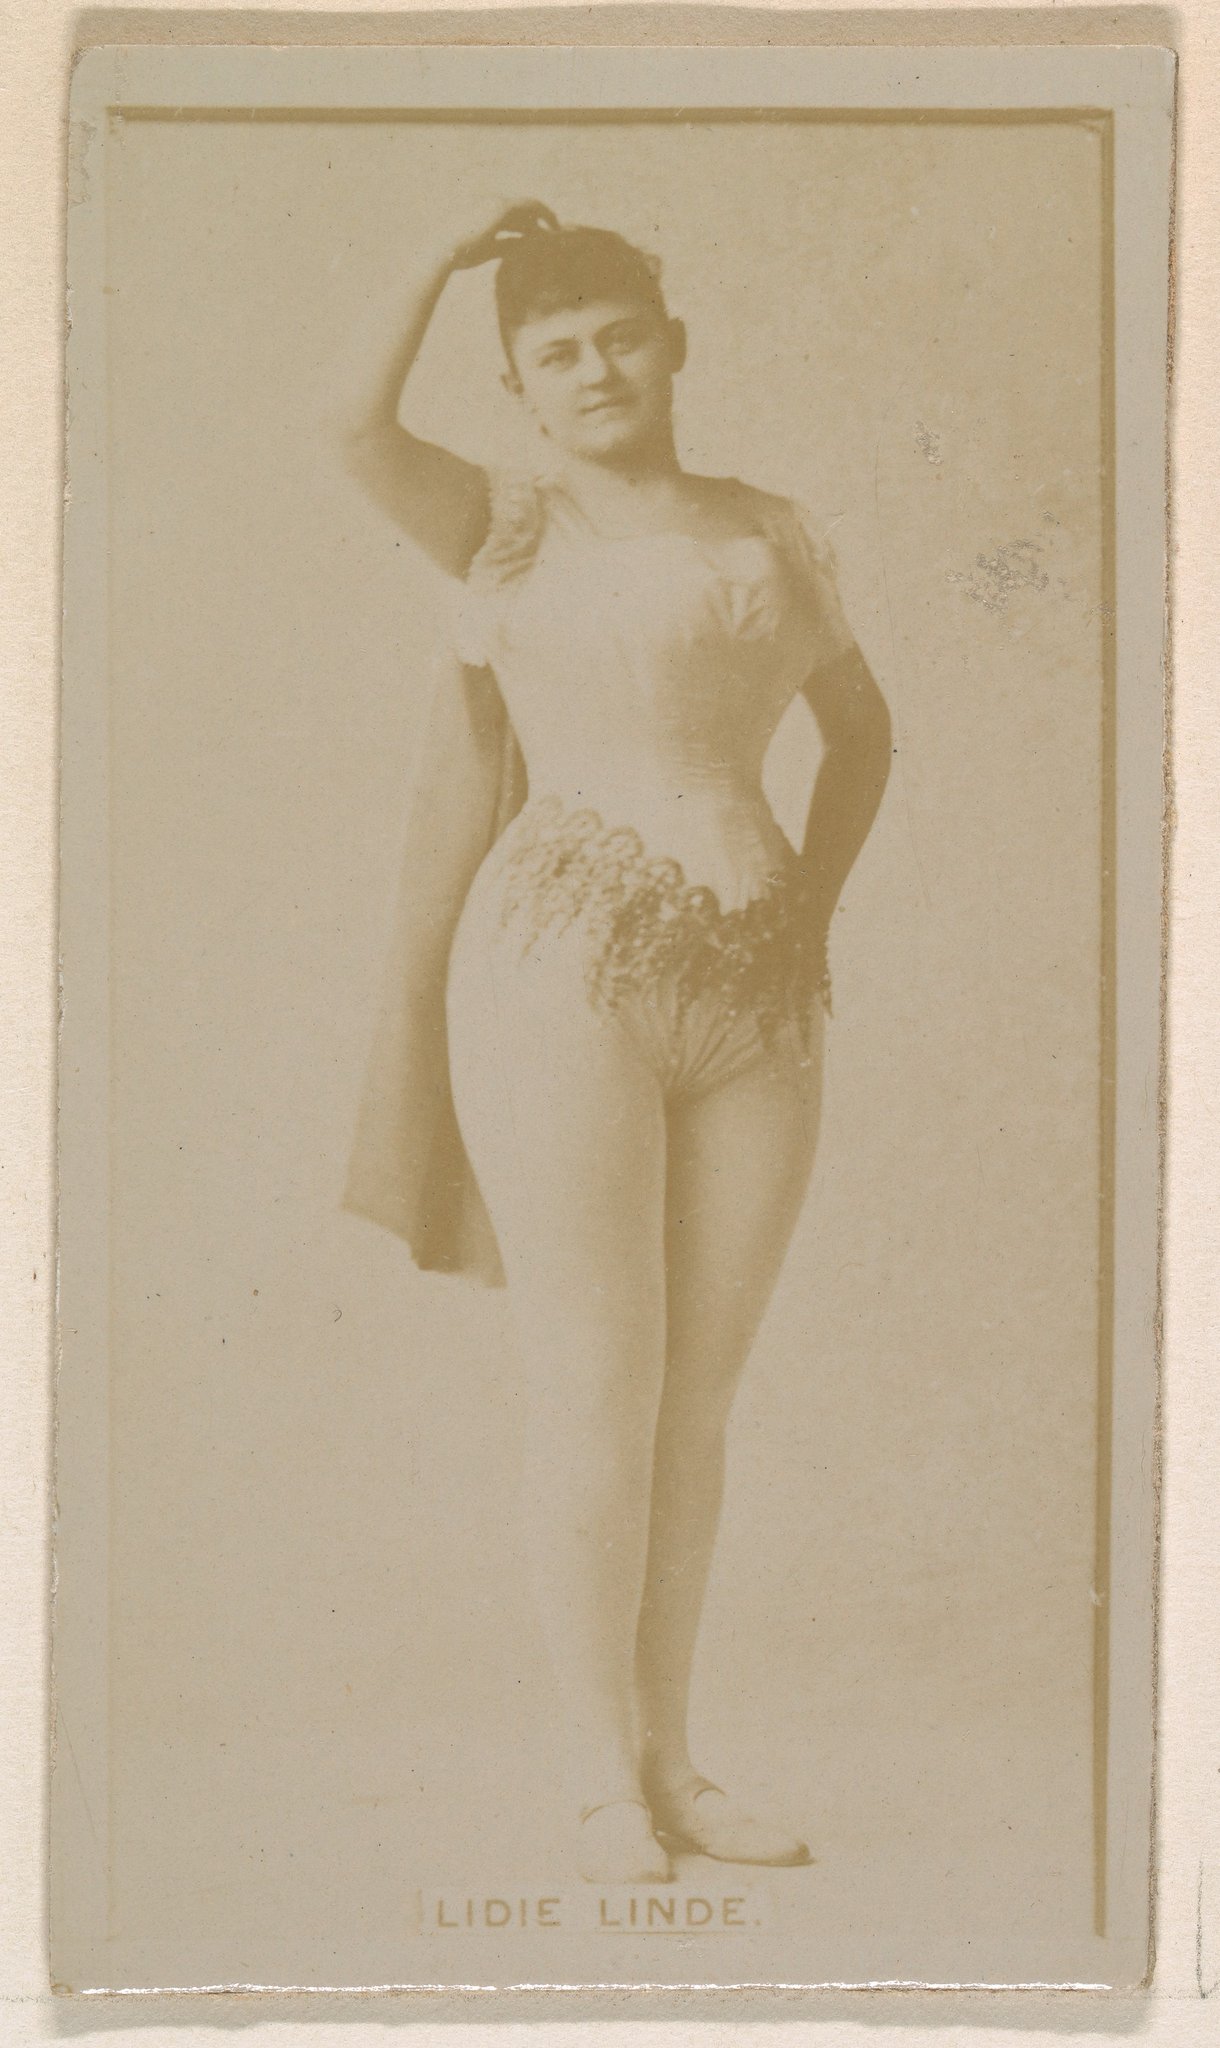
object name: photograph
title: Lidie Linde, from the Actresses series (N245) issued by Kinney Brothers to promote Sweet Caporal Cigarettes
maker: kinney brothers tobacco company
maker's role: publisher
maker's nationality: american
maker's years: 1869-2011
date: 1890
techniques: albumen silver print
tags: portraits,women,actresses